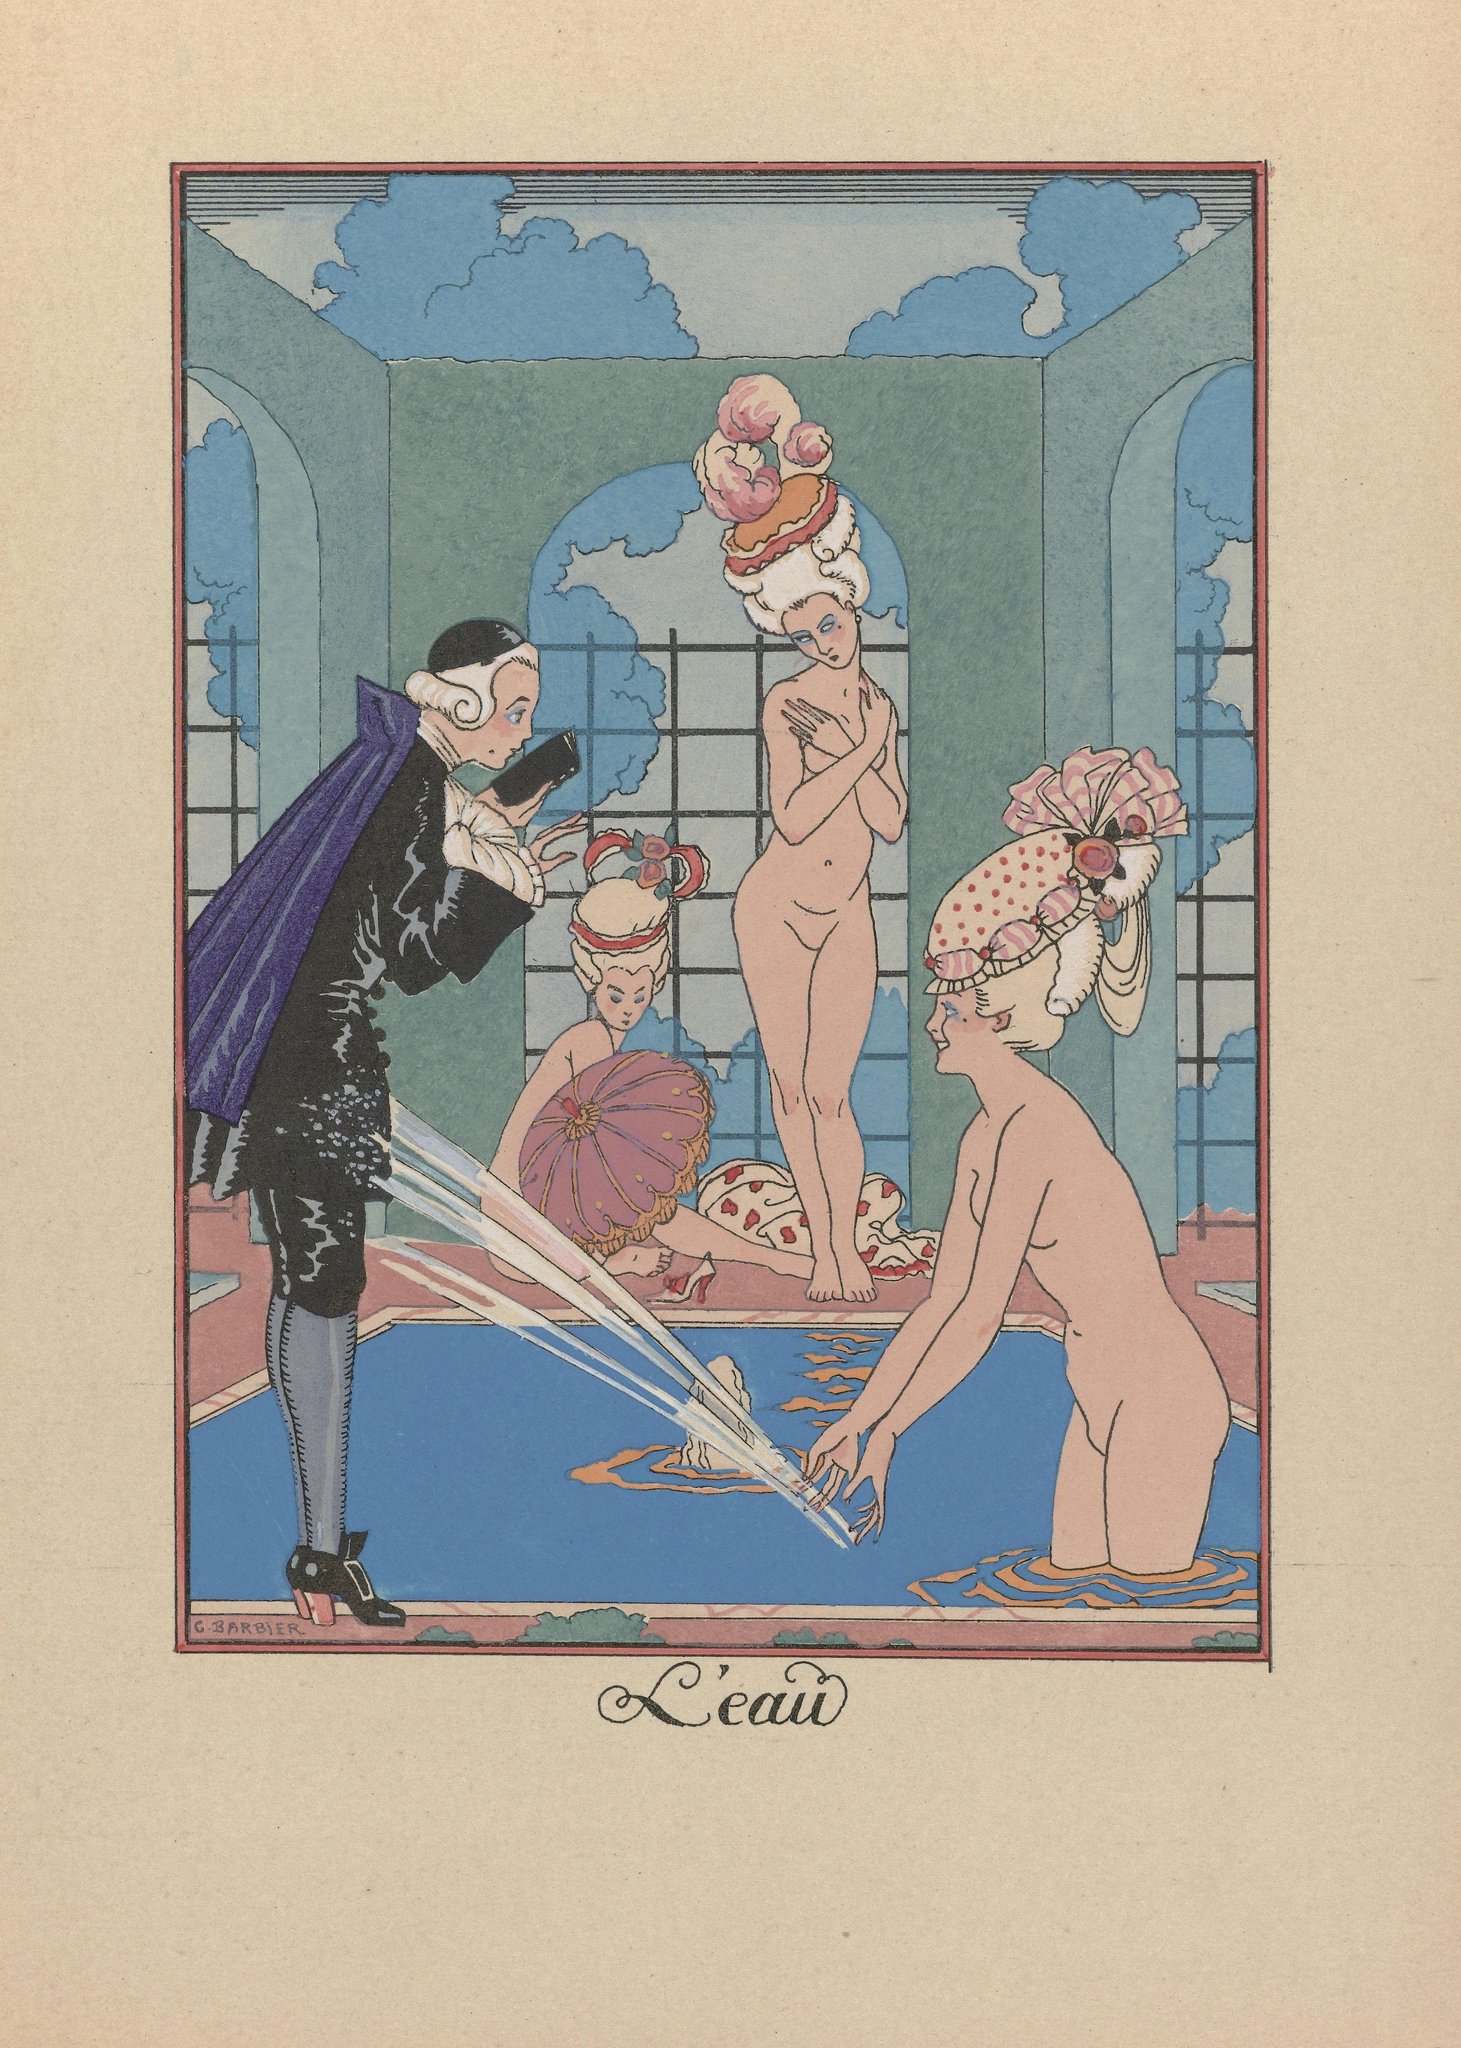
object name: fashion print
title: La Guirlande des mois, 1917-1920 : L'Eau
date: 1917-1920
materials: paper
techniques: hand coloring, lithograph, pochoir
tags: swimming (movement in water) - aa - female human figure, abbot, styles of hairdress - aa - ~ women, fashion plates, book - mm - book open, the (nude) human figure; 'corpo humano' (ripa) - aa - female human figure, parasol, sunshade (+ women's clothes)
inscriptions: caption: ‘L'Eau’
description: Een abt wordt natgespetterd door een naakte vrouw in een vijver. Hij draagt een cape, zwarte frak en kniebroek. Op het hoofd een kalot. Zwarte schoenen met vierkante gespen en rode hakken. Op de achtergrond nog twee ontklede vrouwen met identieke gedecoreerde en hoge kapsels. De kleding en haarstijlen zijn volgens de mode uit de tweede helft van de achttiende eeuw. De prent maakt waarschijnlijk deel uit van de almanak La Guirlande des mois (1917-1920) van George Barbier.